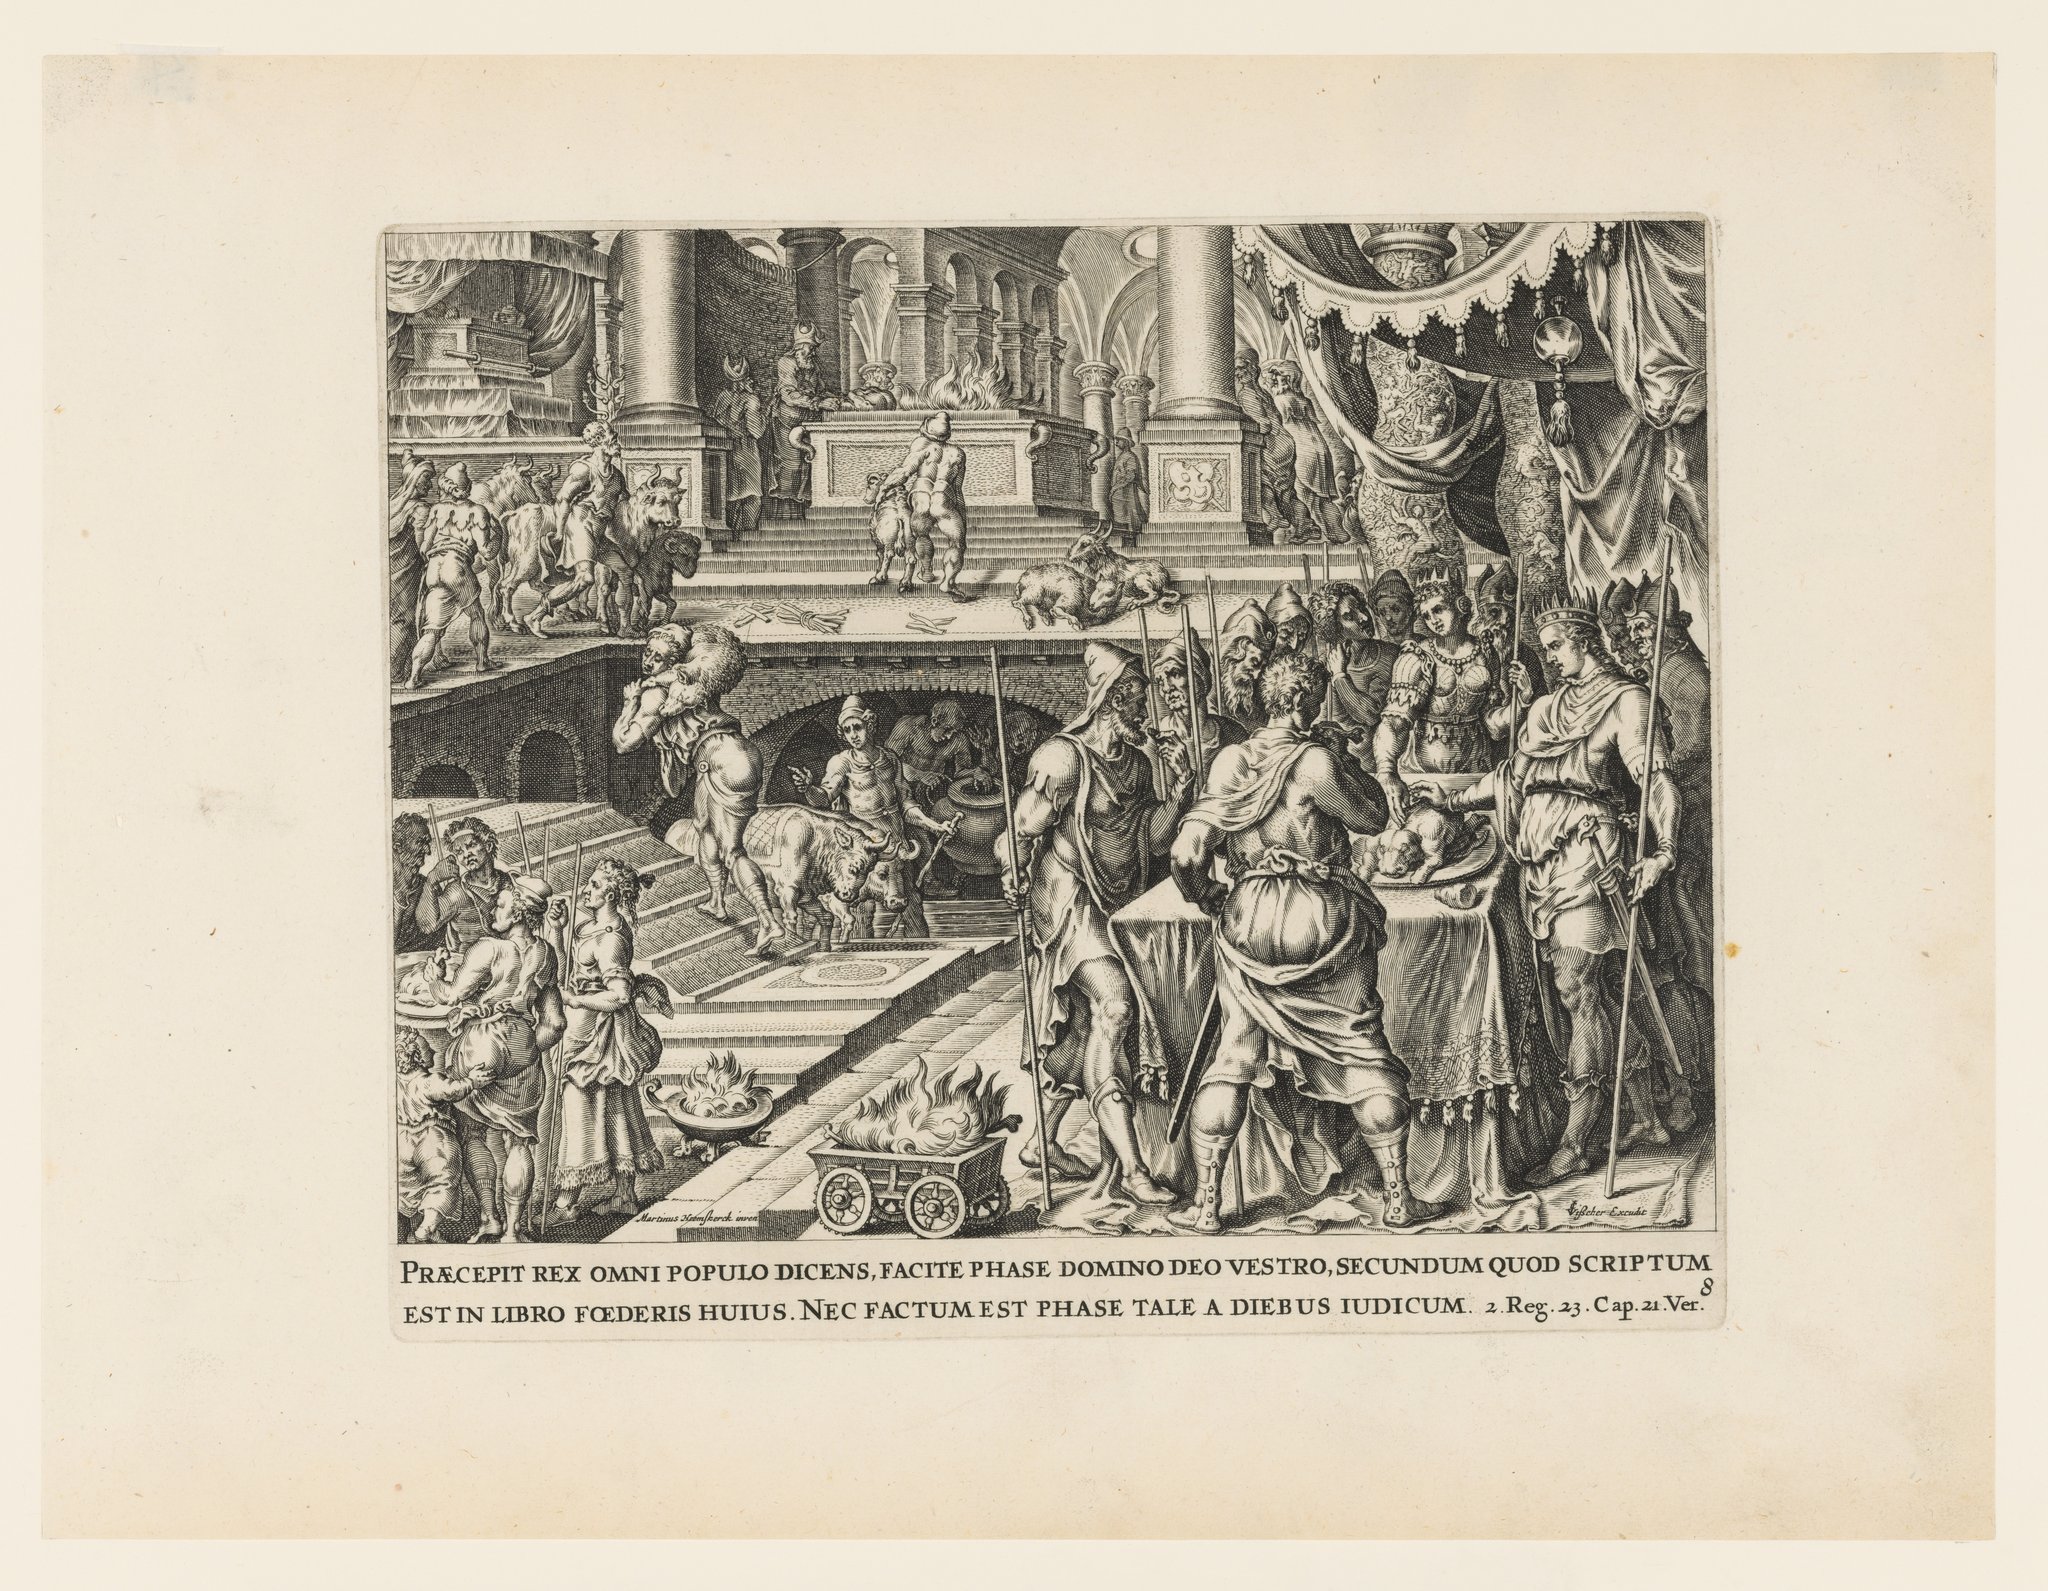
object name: print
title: Josiah Celebrating Passover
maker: claes jansz. visscher (ii)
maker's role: artist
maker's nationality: dutch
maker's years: 1586-1652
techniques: engraving